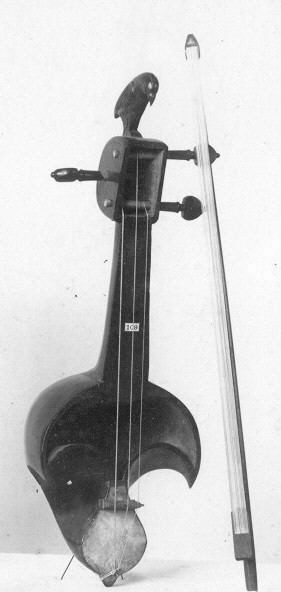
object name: sārindā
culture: indian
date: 1801-1900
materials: wood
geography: india